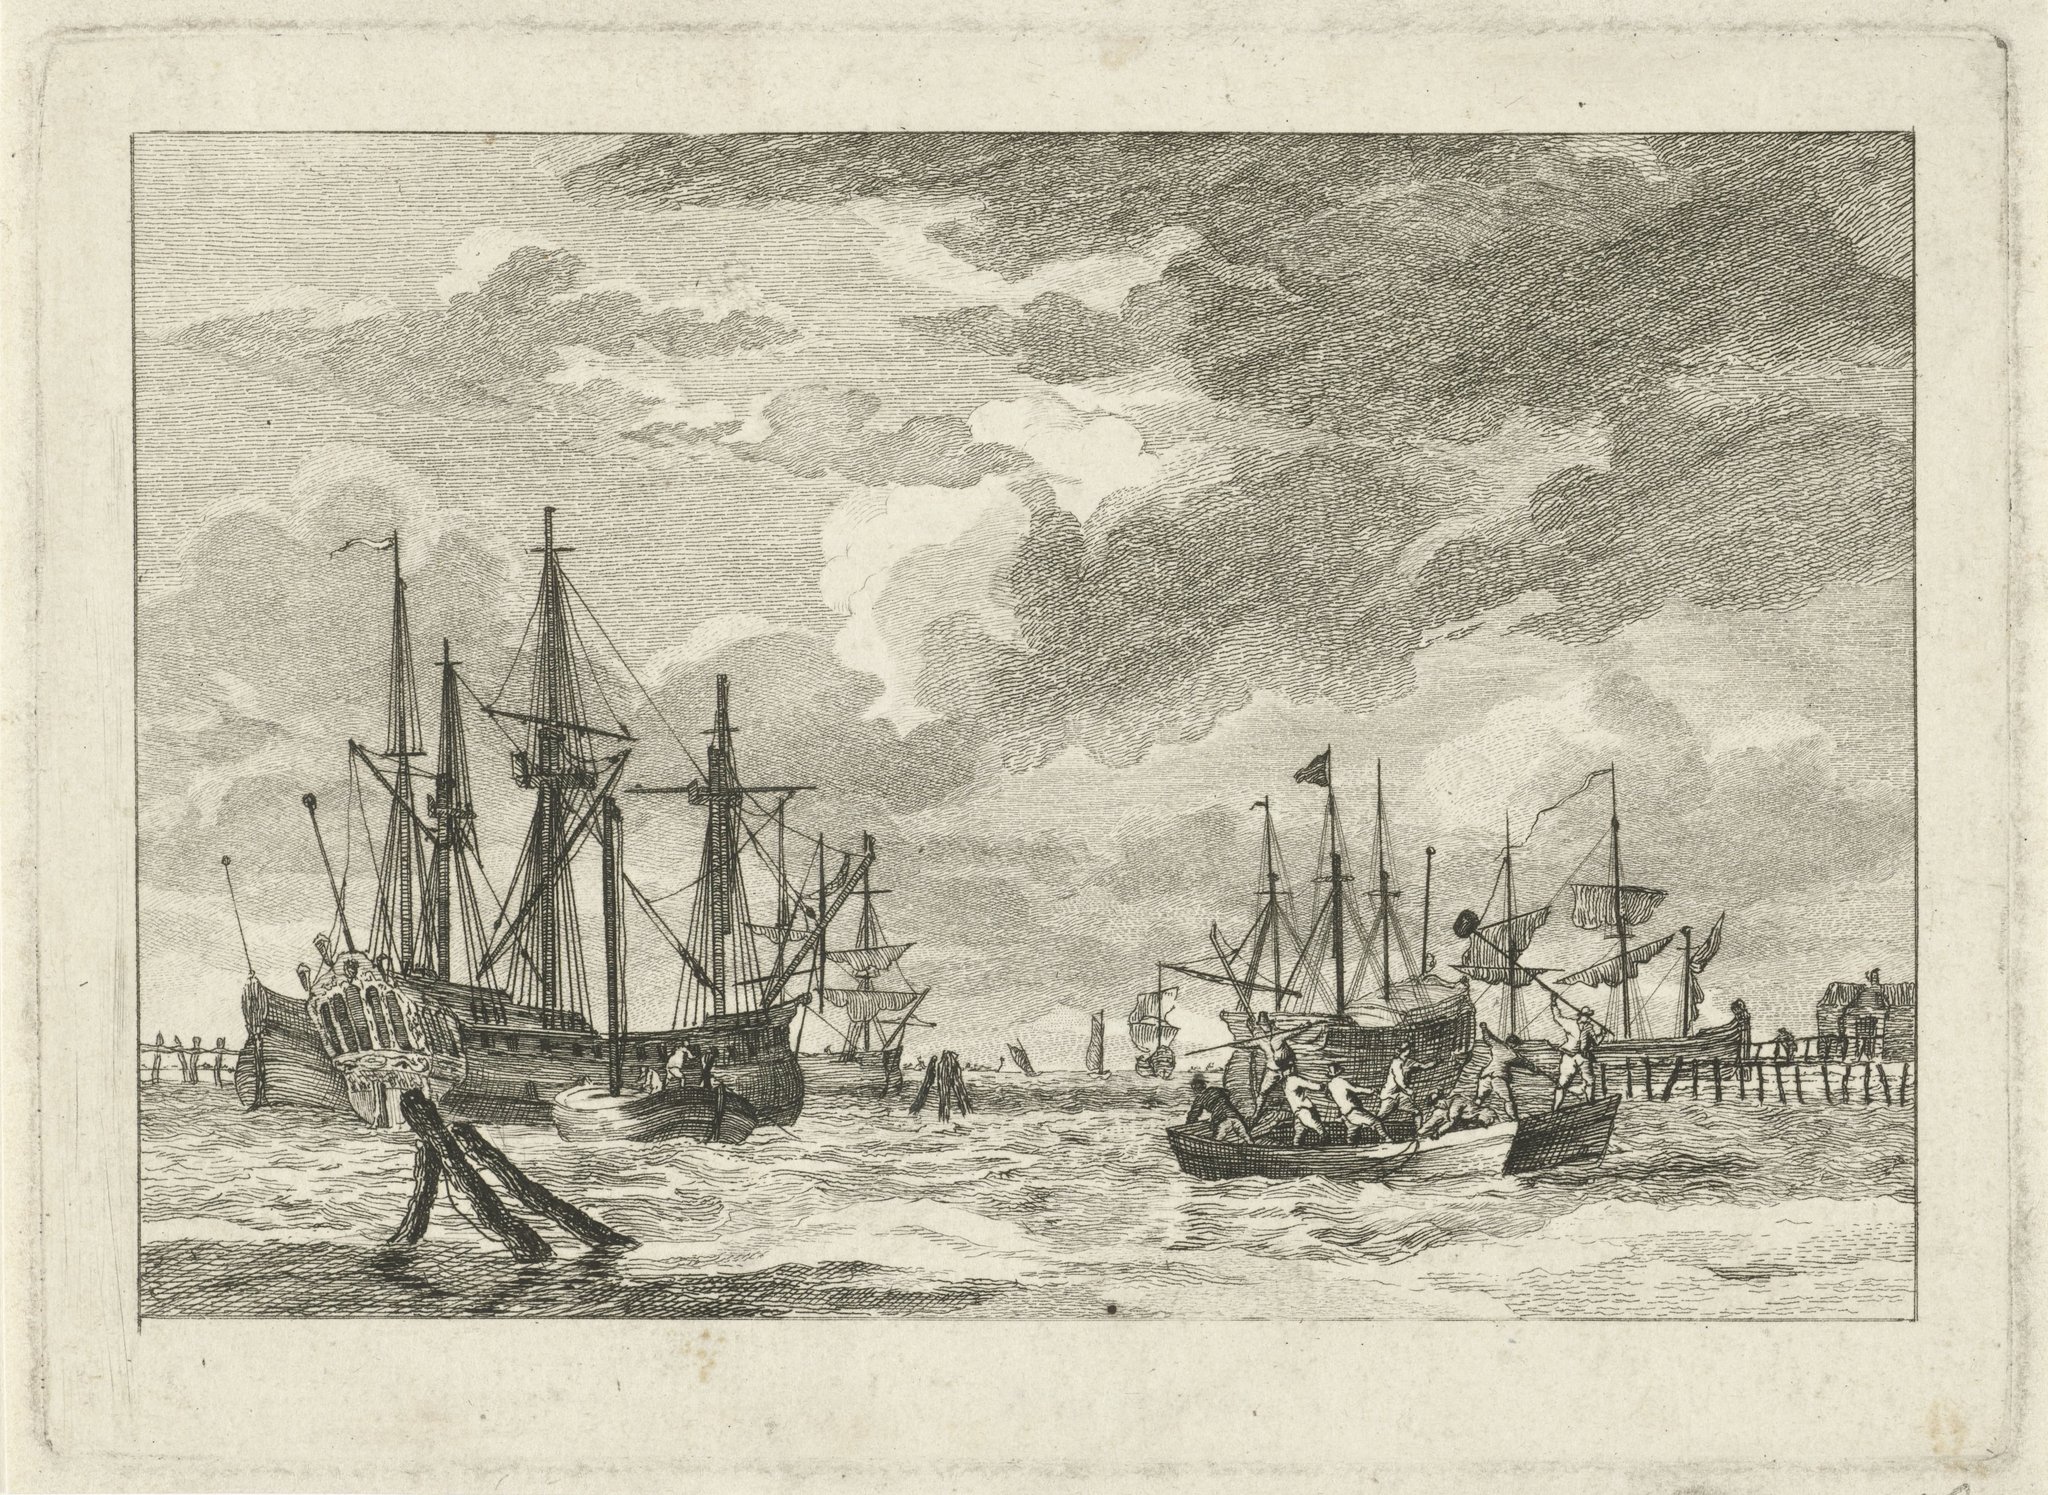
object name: print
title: Schepen en sloepen in een haven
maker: gerrit groenewegen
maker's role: draughtsman, print maker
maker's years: 1754-1826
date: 1764-1826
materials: paper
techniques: engraving, etching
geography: rotterdam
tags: harbour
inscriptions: collector's mark: Lugt 2228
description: Schepen en sloepen in een haven. Op de rechter sloep zijn acht figuren te zien.